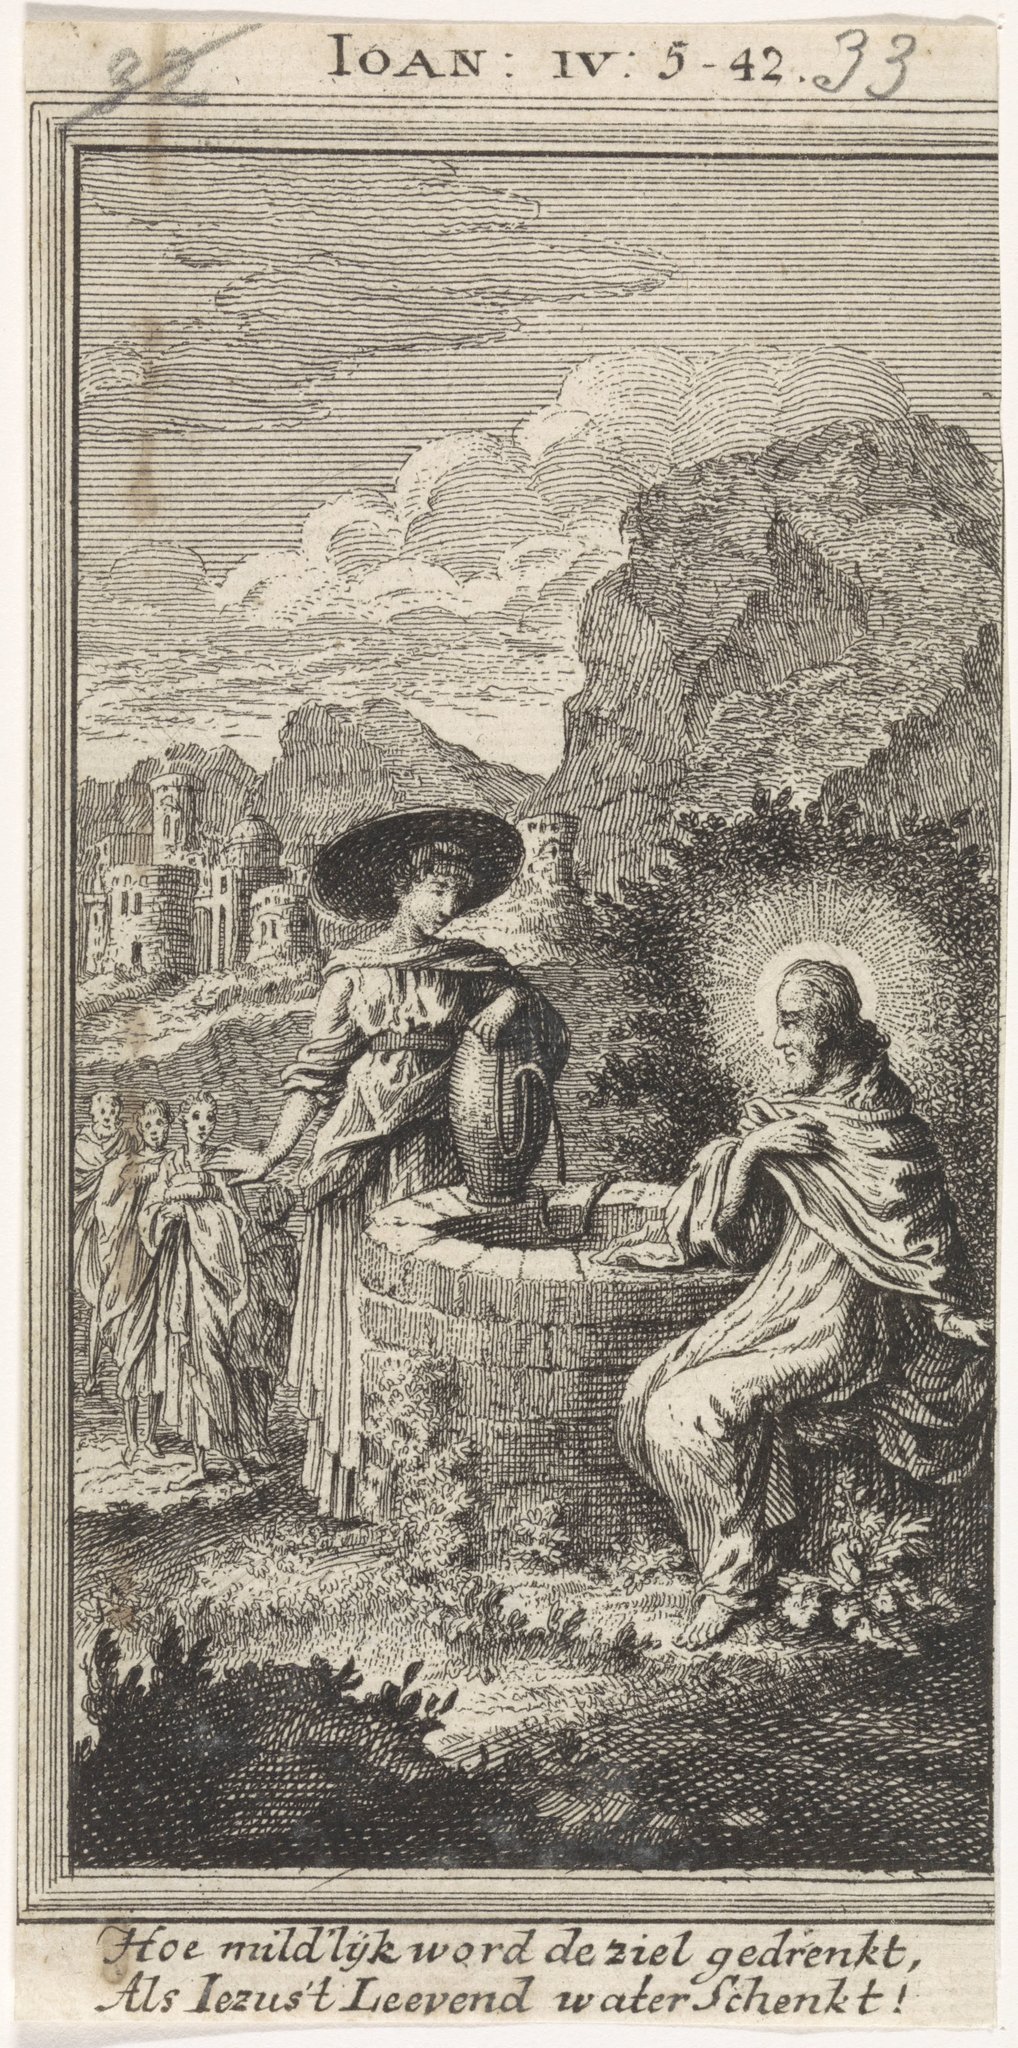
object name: print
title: Christus en de Samaritaanse vrouw bij de put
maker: Anonymous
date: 1712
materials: paper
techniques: etching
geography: amsterdam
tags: well, christ and the woman of samaria: sitting at jacob's well he asks her for a drink from her jug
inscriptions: collector's mark: Lugt 2228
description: Kopie van illustratie voor: Luyken, Jan. Bybel printen. Amsterdam: Pieter Arentsz. II (wed.) en Cornelis van der Sys, 1712, p. 32.